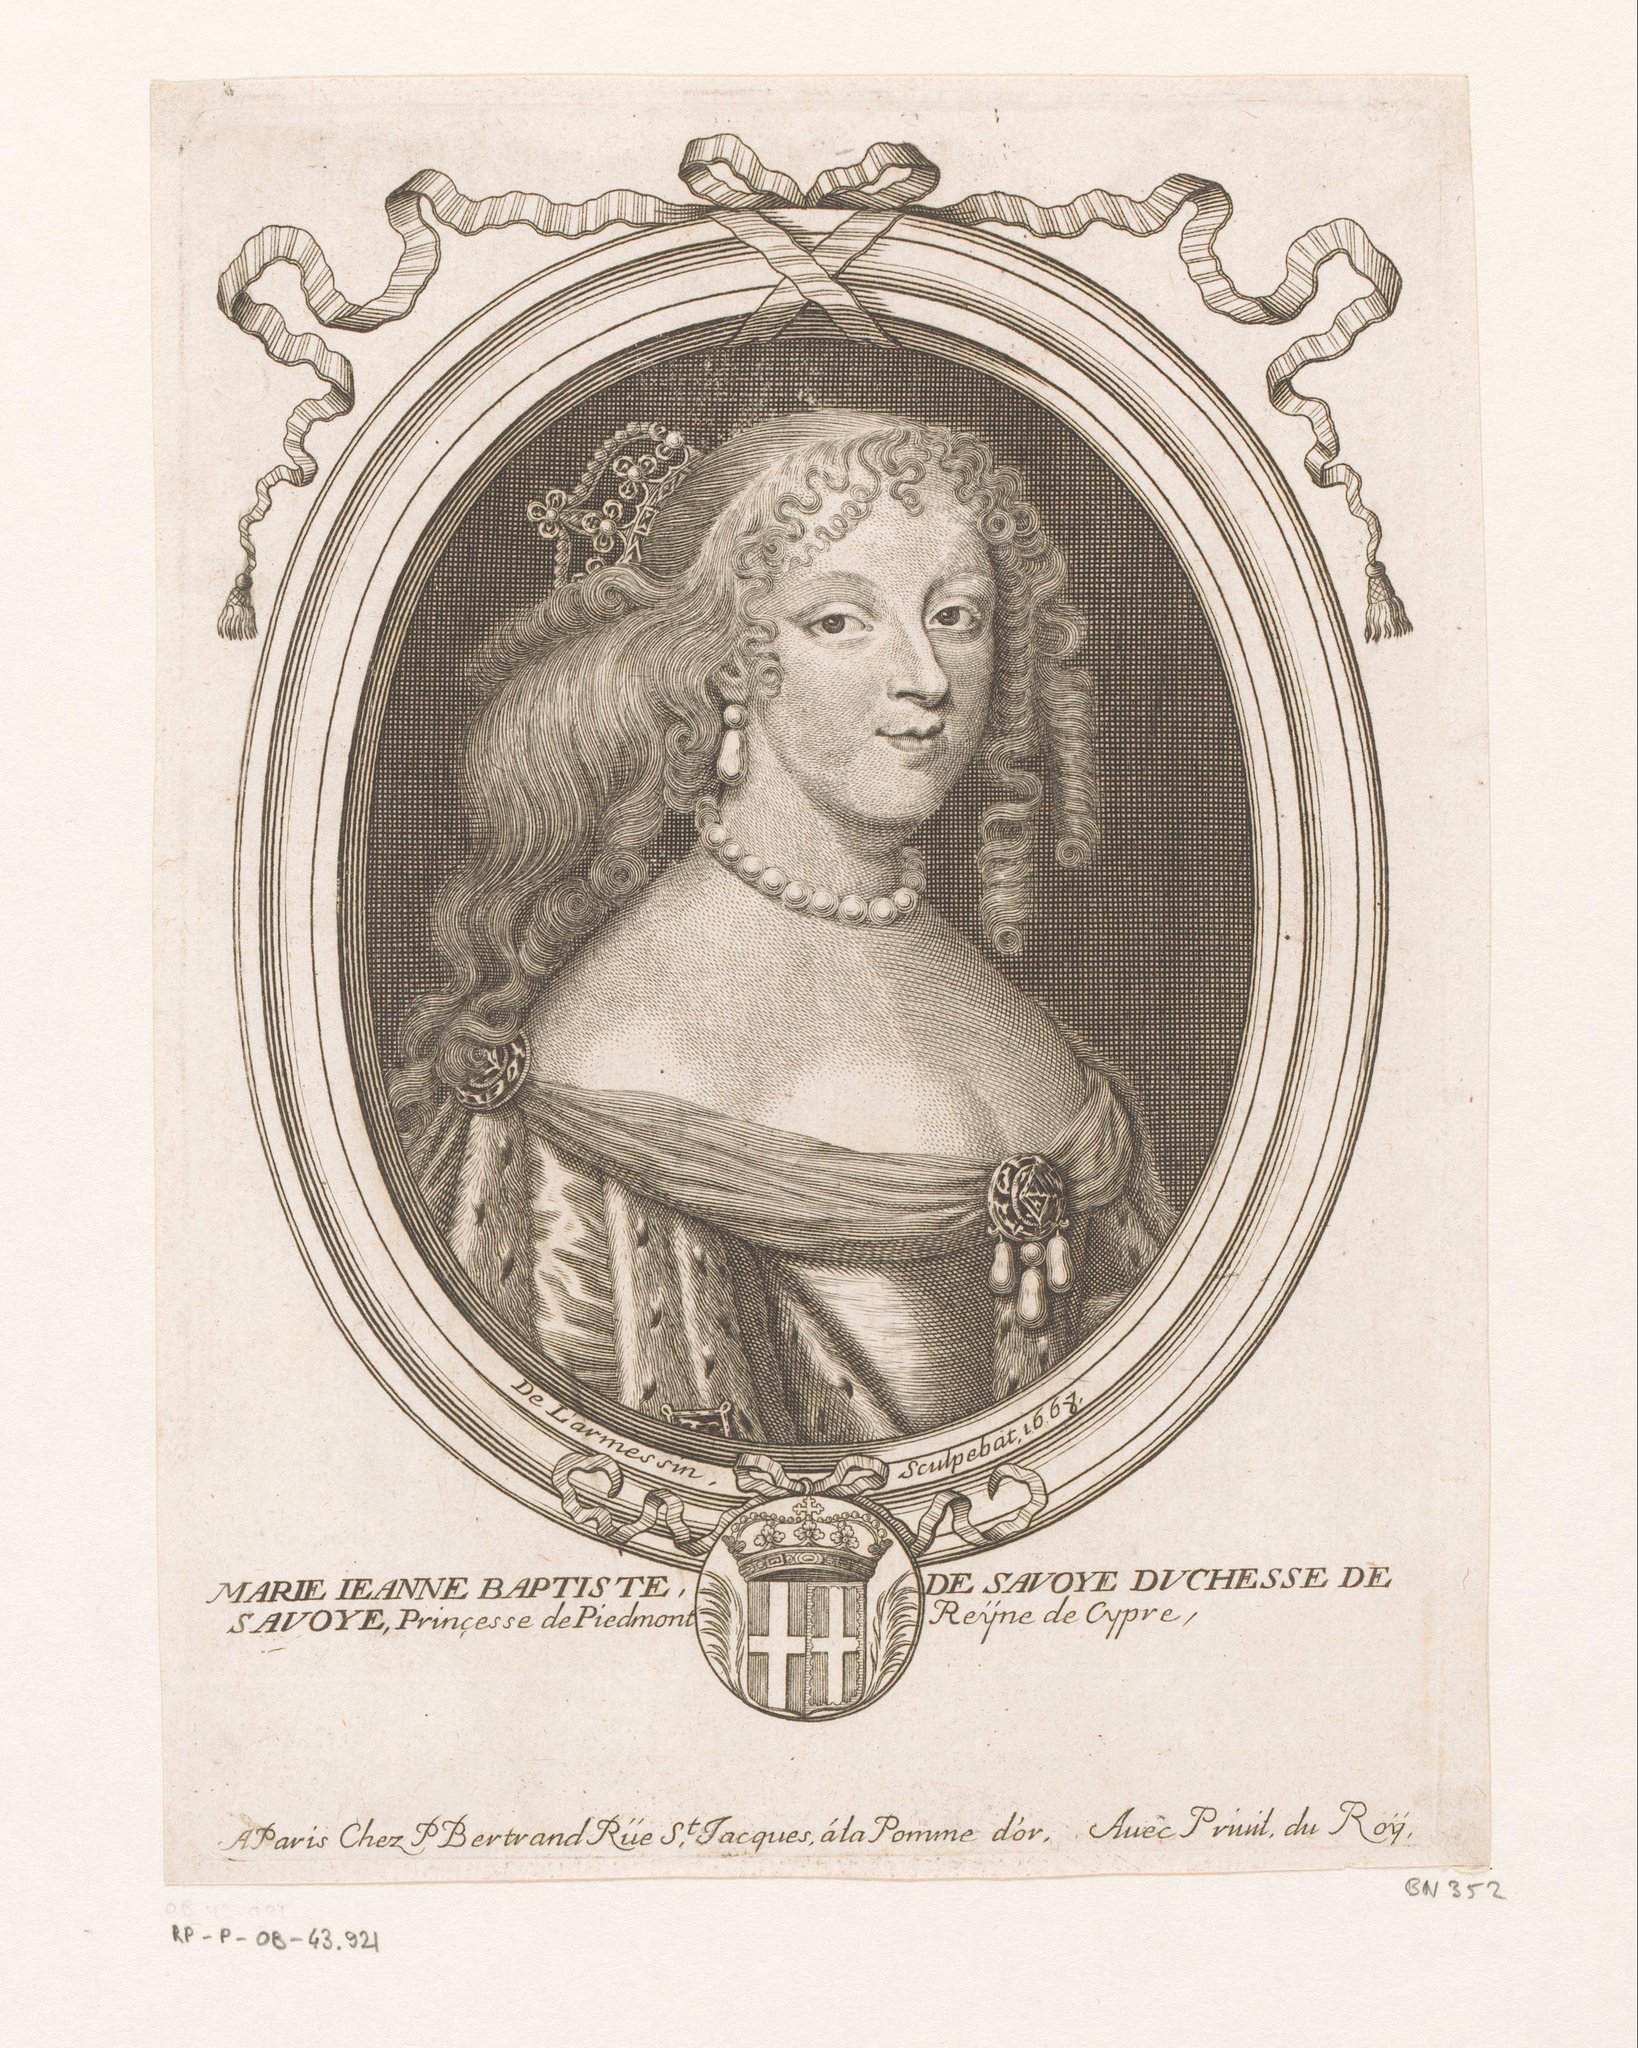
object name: print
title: Portretten van prominente figuren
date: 1668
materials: paper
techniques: engraving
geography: paris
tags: paris, historical persons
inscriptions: collector's mark: Lugt 2228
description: Maakt deel uit van een grootschalige serie met portretten van prominente figuren. Binnen de serie bevindt zich een sectie getiteld 'Les Augustes Représentations De tous les Roys De France depuis Pharamond Iusqu'à Louys XIIII'. De serie werd respectievelijk uitgegeven door Pierre Bertrand, door zijn weduwe en door De Larmessin zelf.